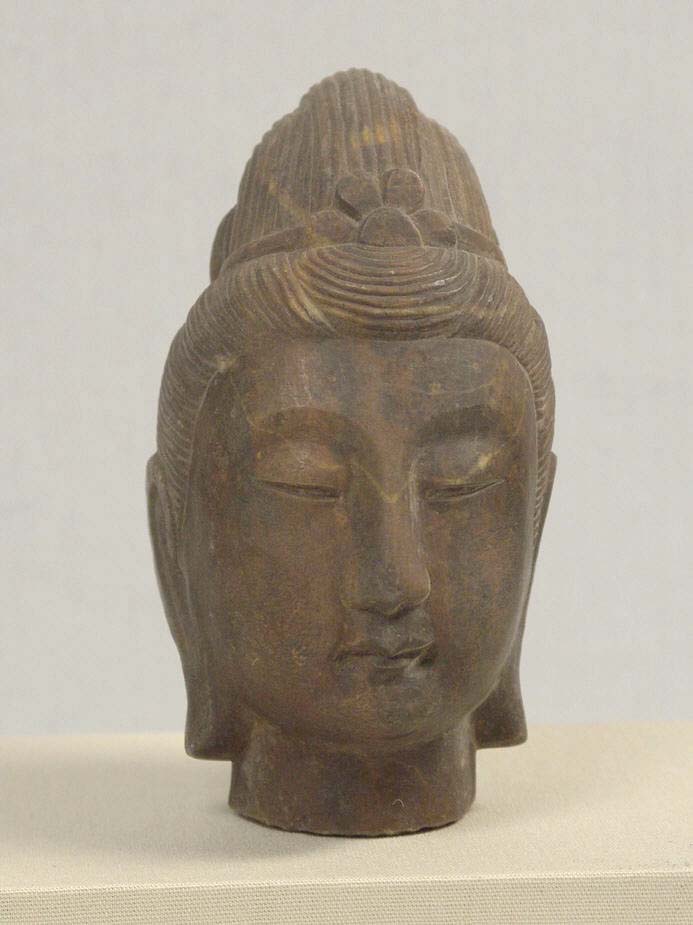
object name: head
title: Head of a bodhisattva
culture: chinese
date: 501-600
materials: stone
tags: heads